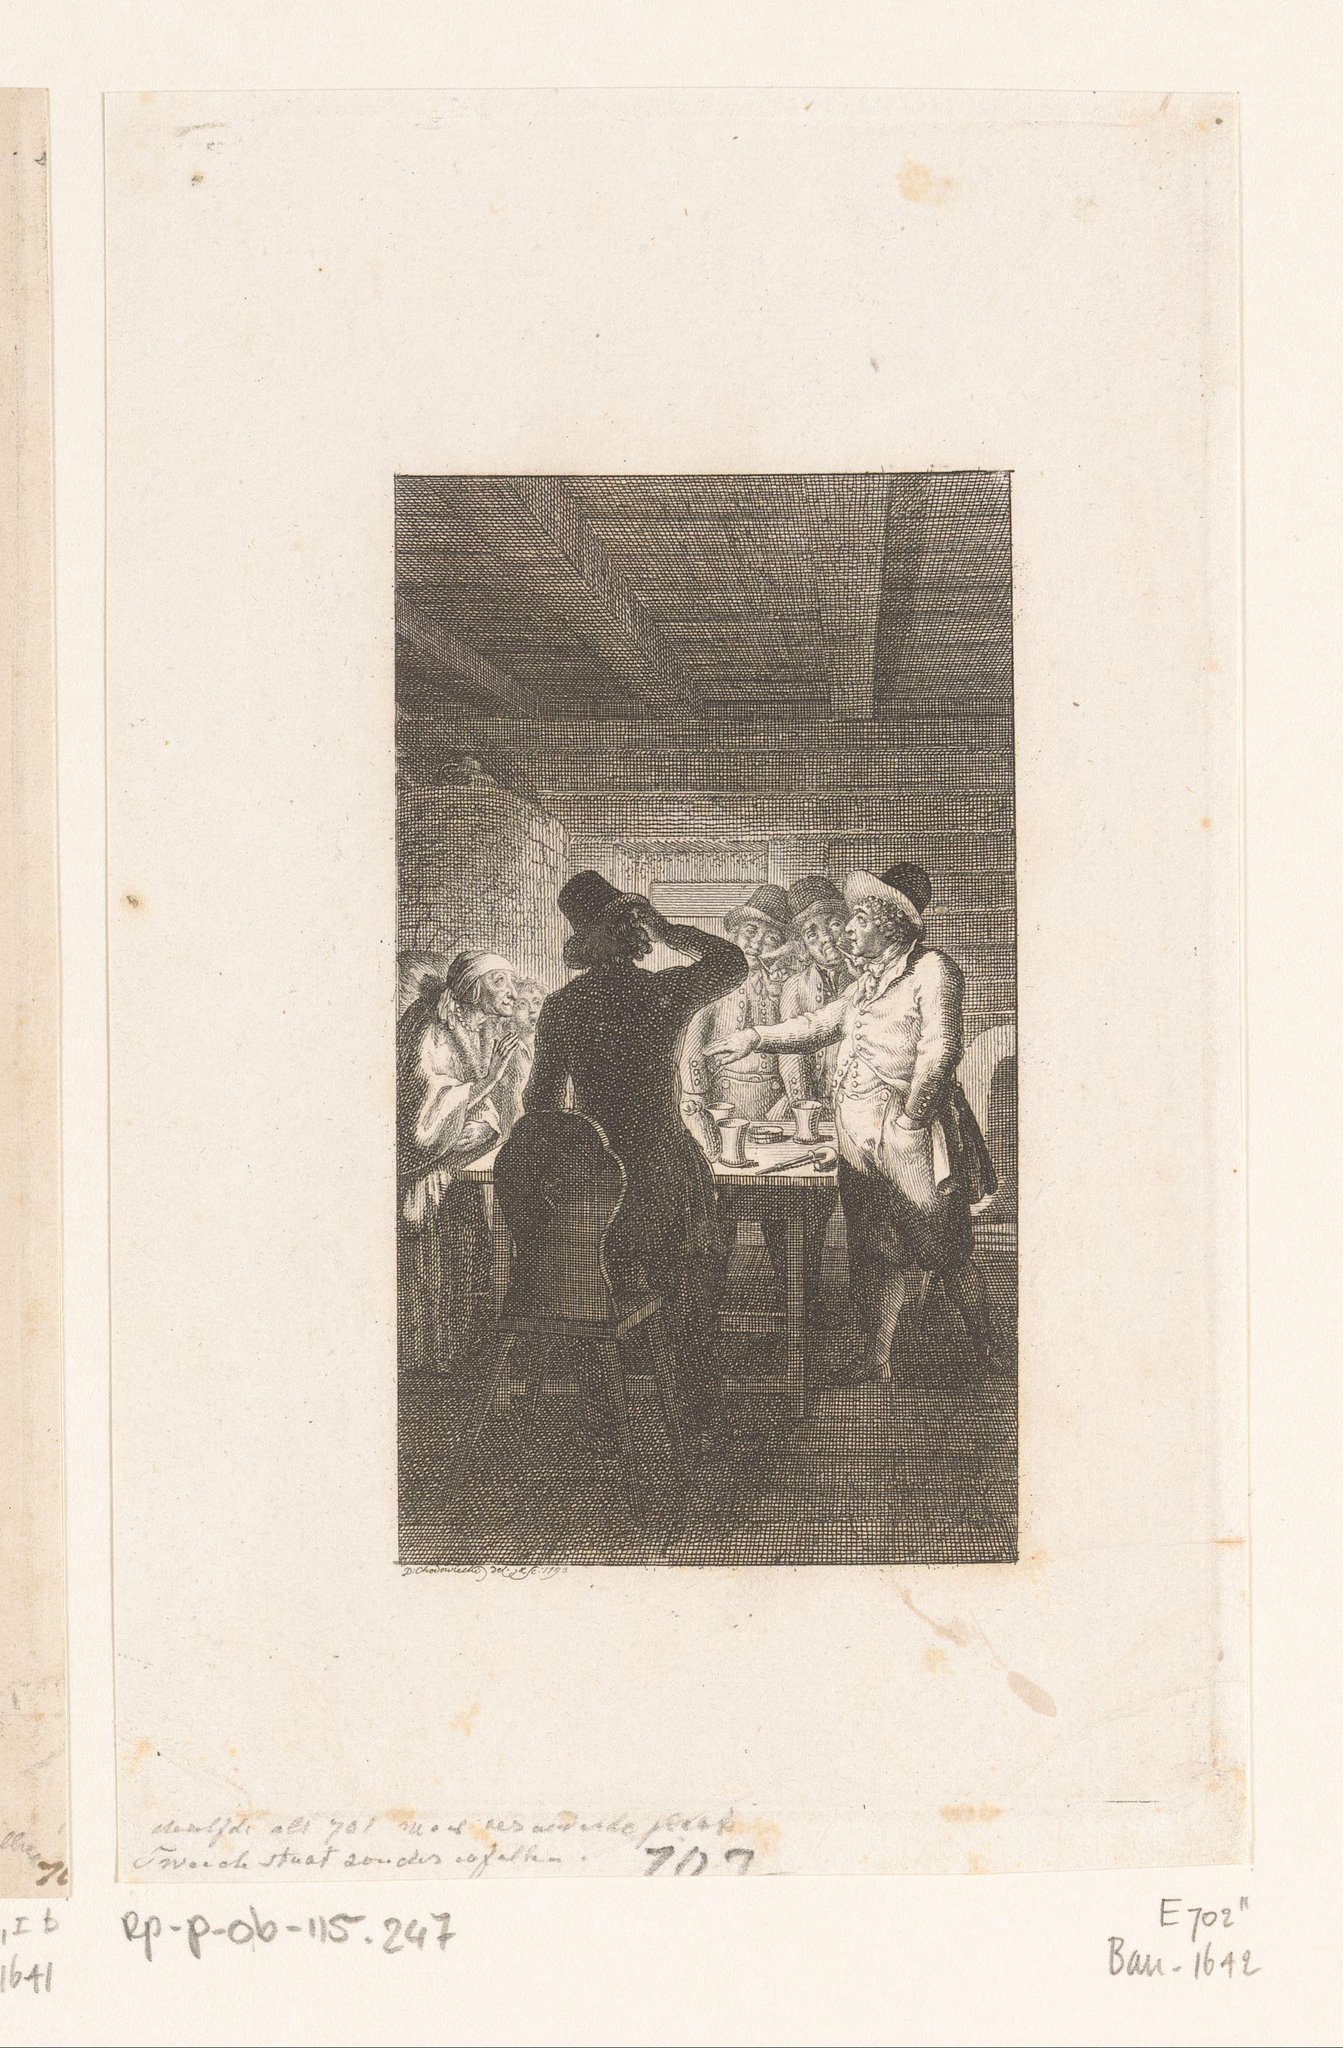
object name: print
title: Herbergbezoekers zetten een zak geld voor de waardin op tafel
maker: daniel nikolaus chodowiecki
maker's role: draughtsman, print maker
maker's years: 1726-1801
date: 1793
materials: paper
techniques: etching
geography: berlin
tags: purse, money-bag, literature, travelling; tourism, hotel, hostelry, inn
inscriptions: collector's mark: Lugt 2228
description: Prent gebruikt voor: Storch, Heinrich. Gemählde von St. Petersburg. 2 dln. Riga: Johann Friedrich Hartknoch, 1794, dl. 2.